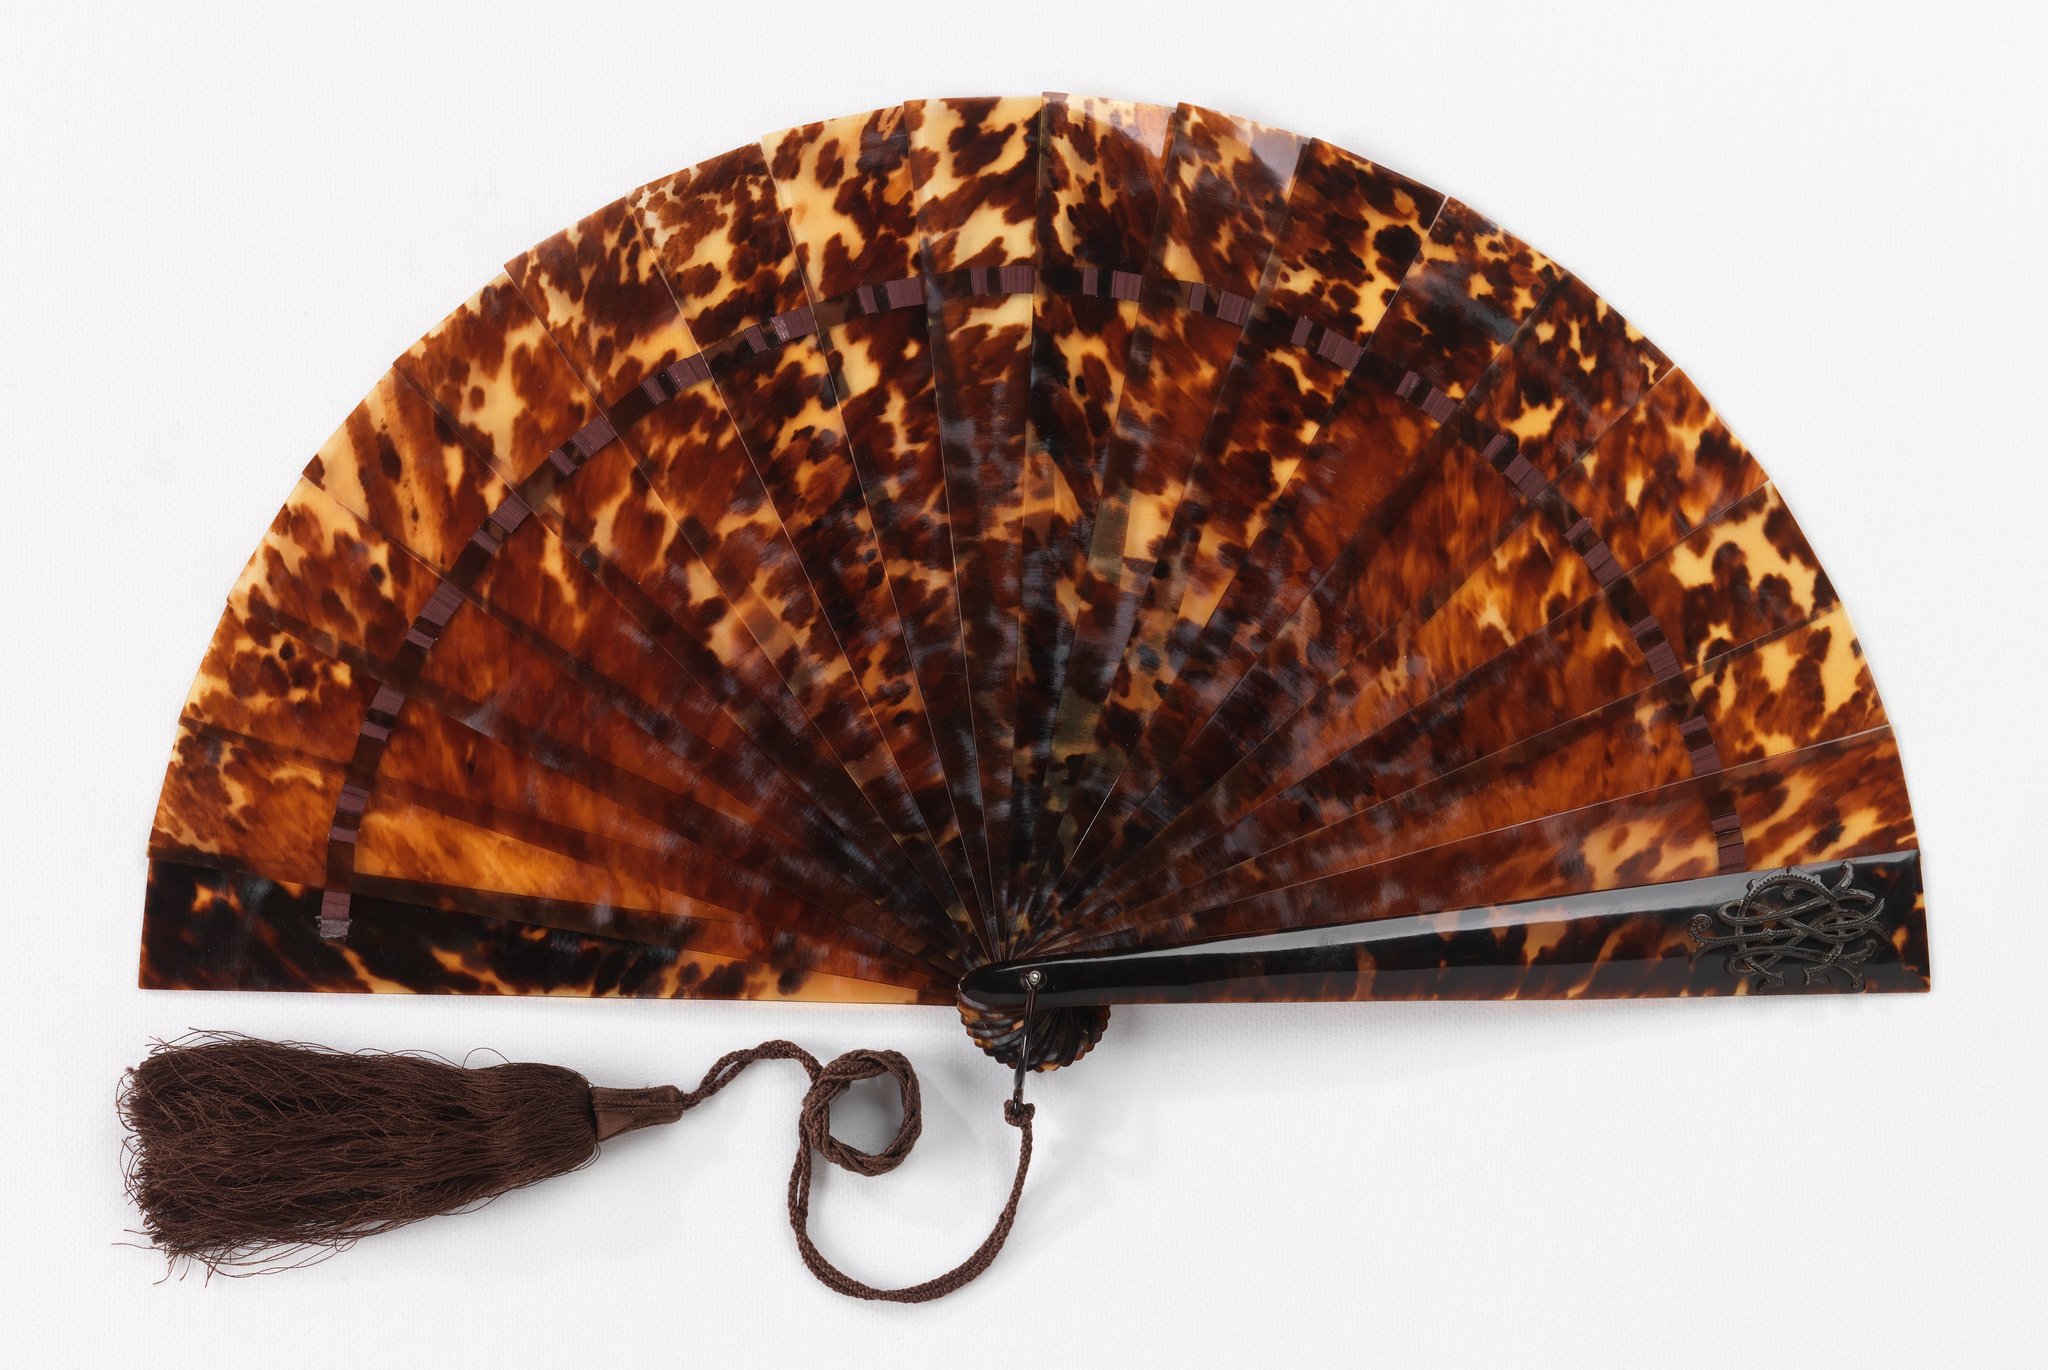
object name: brisé fan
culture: french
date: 1875-1889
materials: plastic, silk, shell